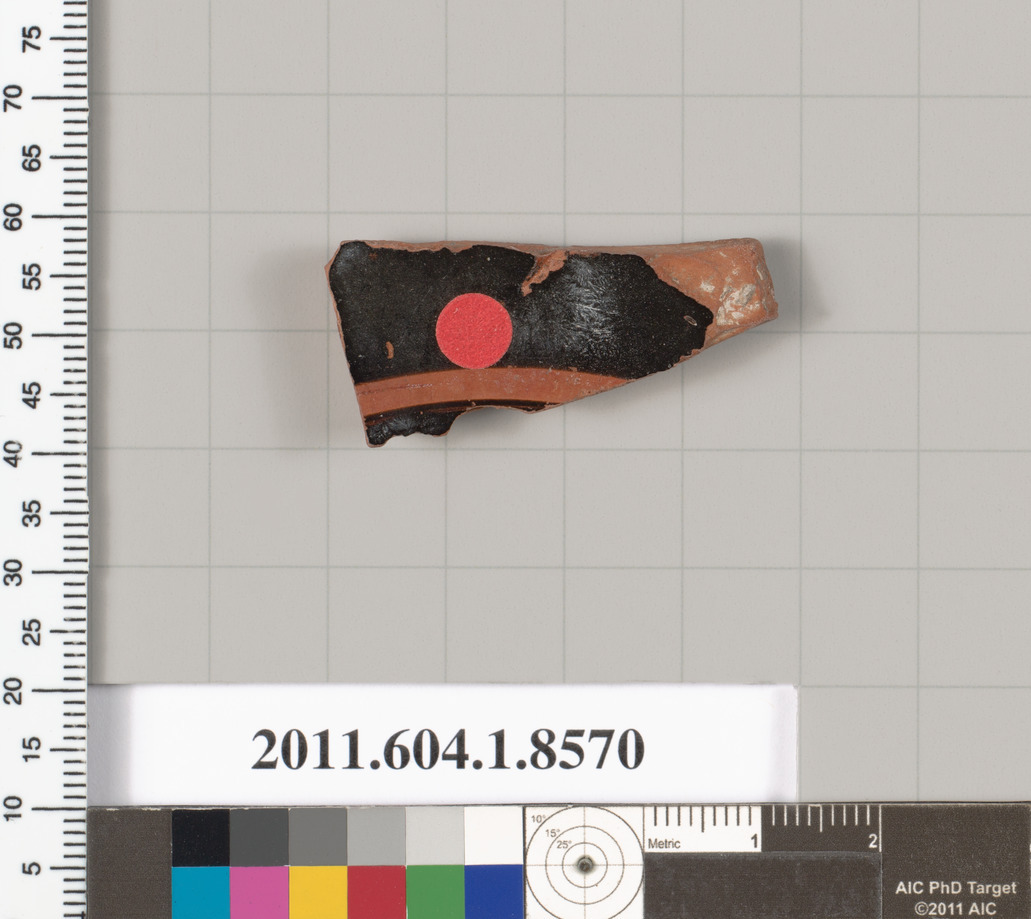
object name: kylix fragment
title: Terracotta fragment of a stemless kylix (drinking cup)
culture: greek, attic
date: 470-450 BCE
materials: terracotta